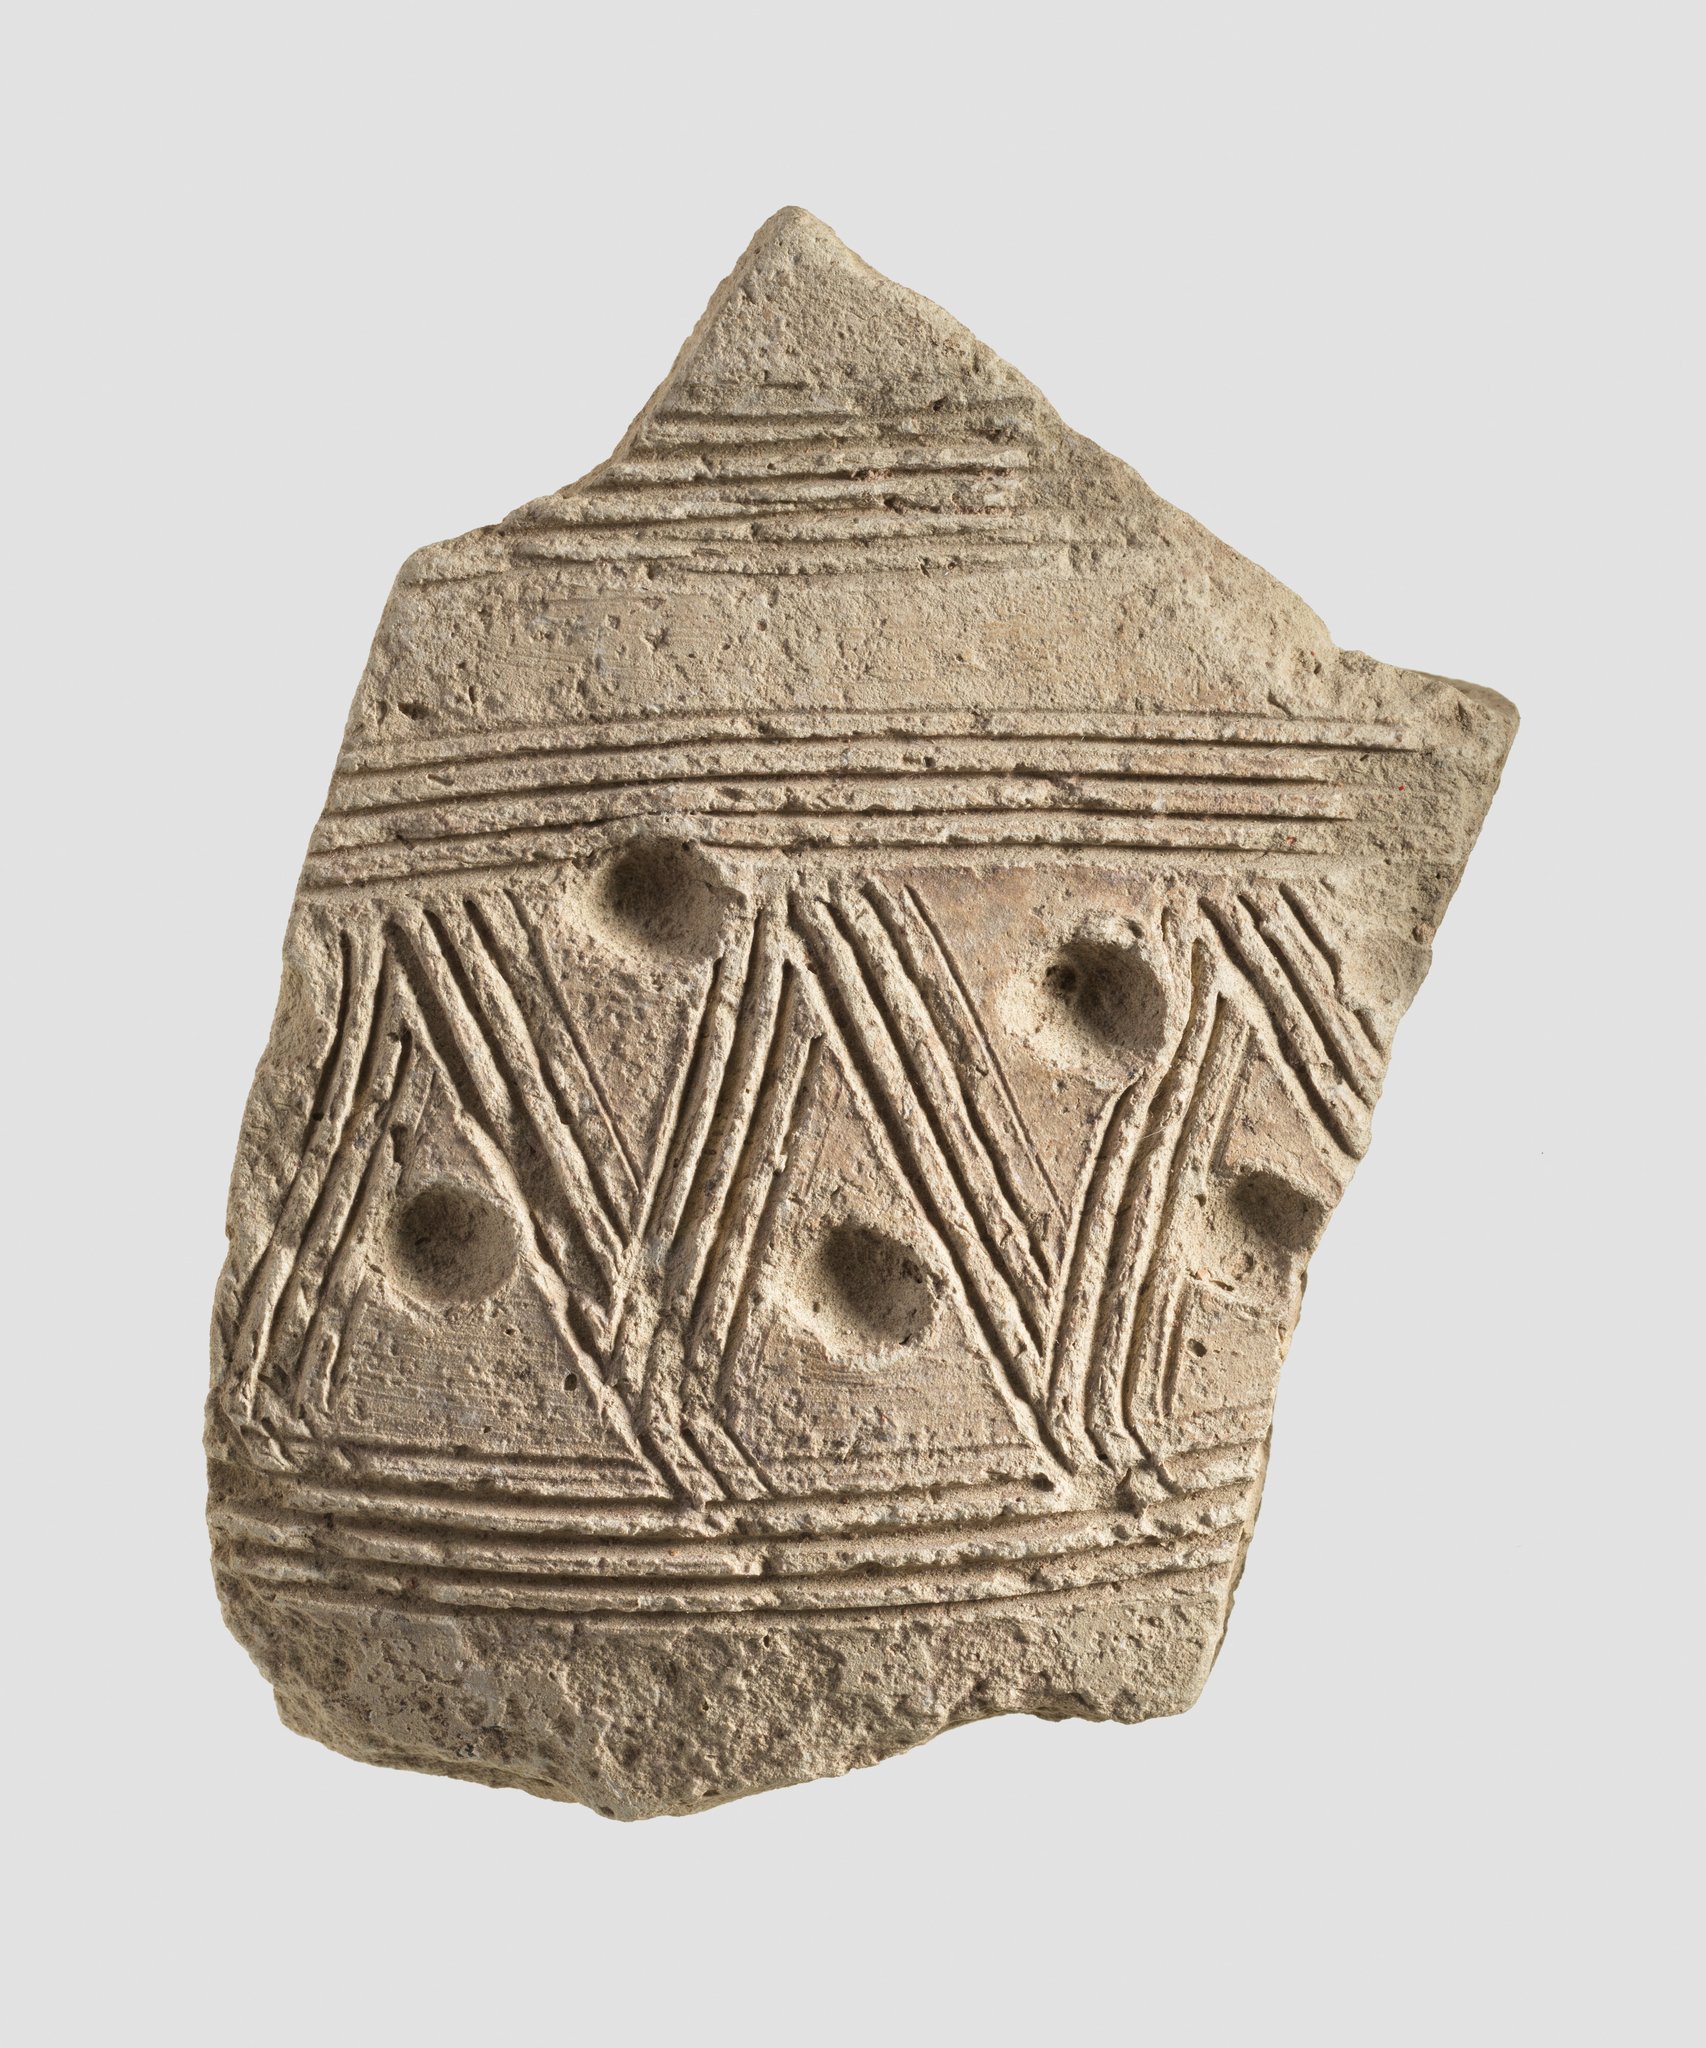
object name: sherd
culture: parthian or sasanian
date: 201-700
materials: ceramic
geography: mesopotamia